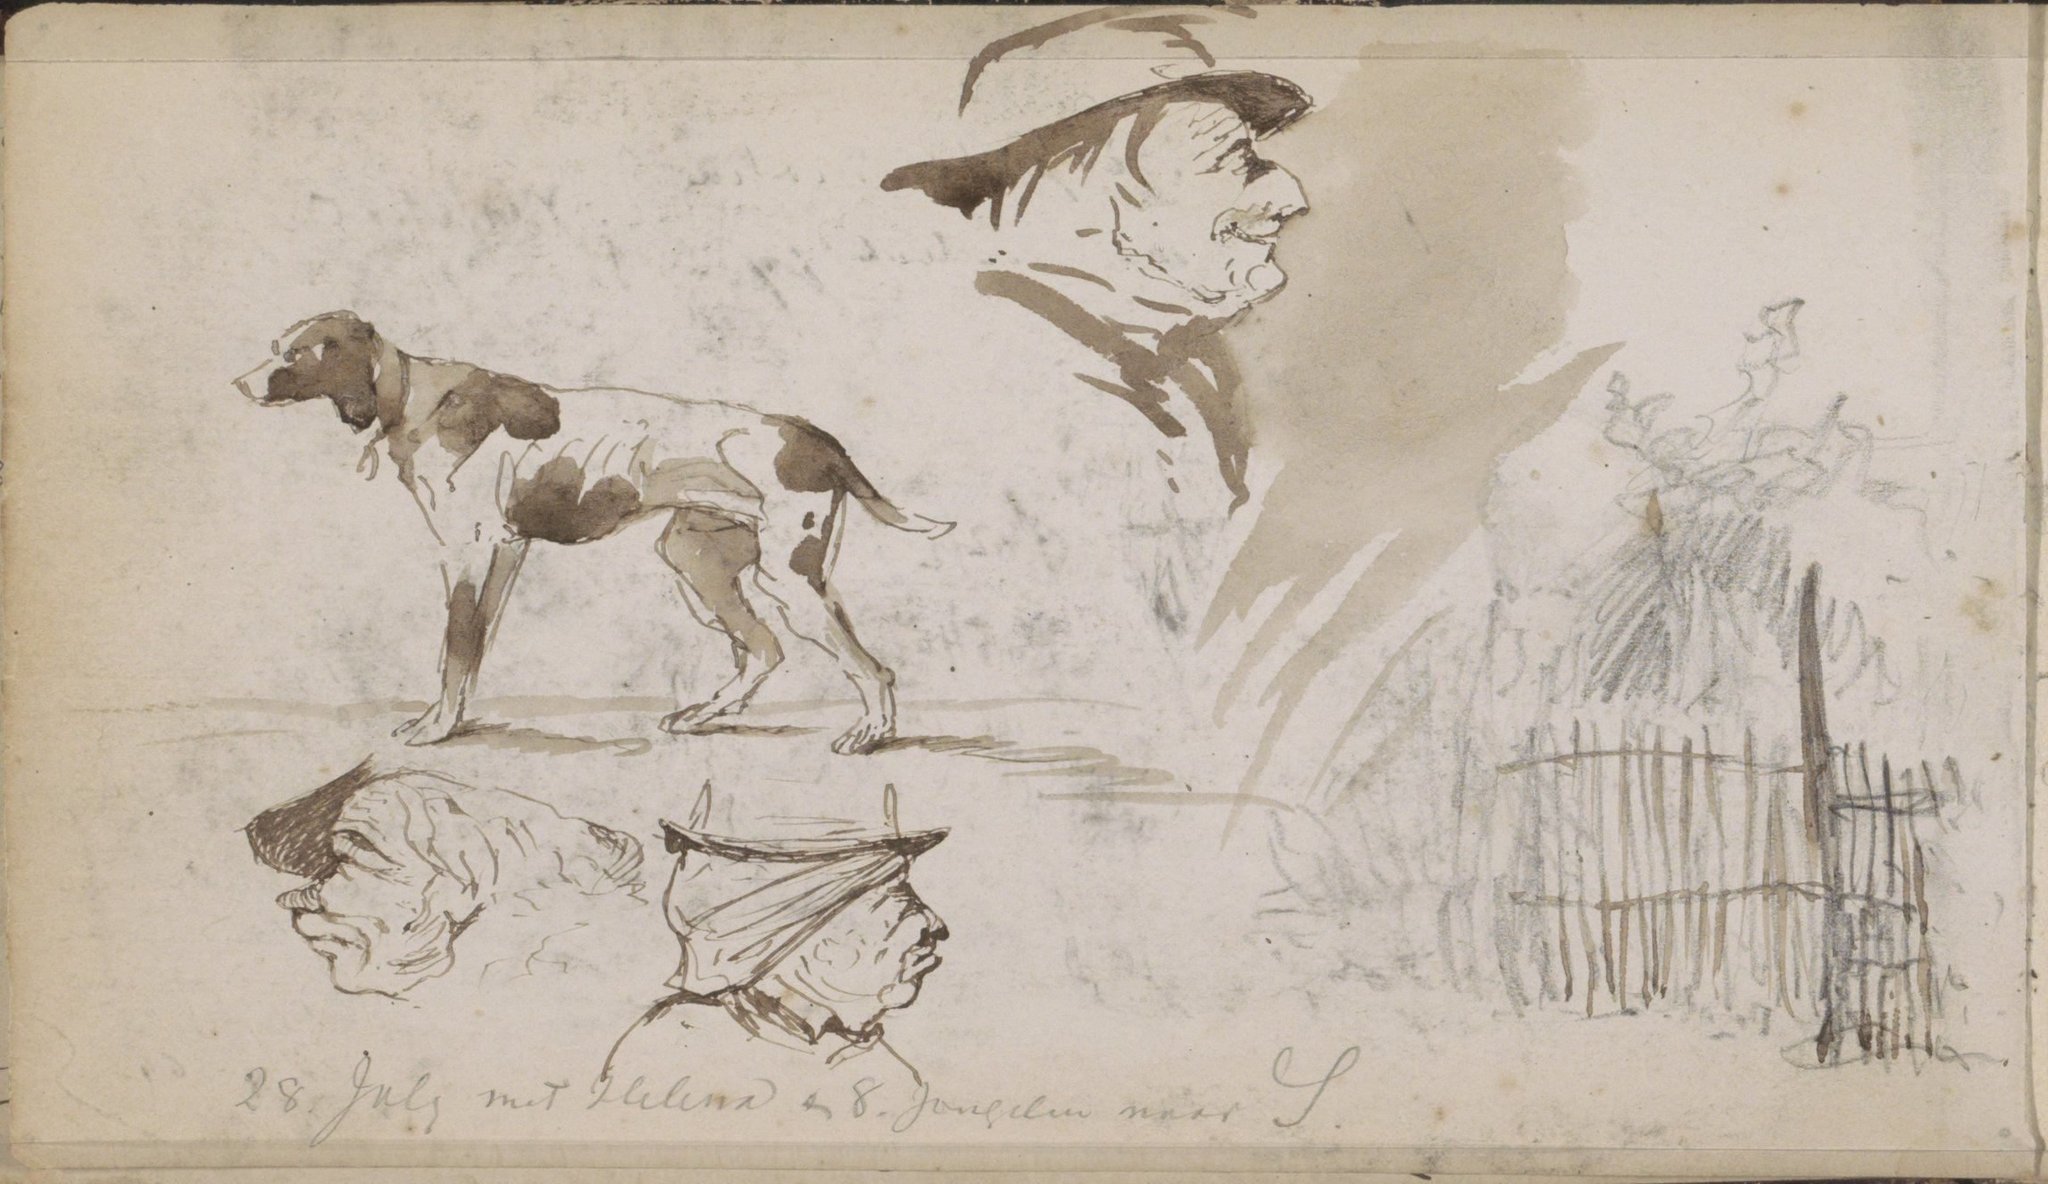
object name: sketchbook leaf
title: Hond en twee mannenkoppen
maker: johannes tavenraat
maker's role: draughtsman, painter, print maker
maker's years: 1809-1881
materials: ink, paper, pencil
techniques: pen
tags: head (human), adult man, head-gear: hat (+ men's clothes), dog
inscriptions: date and inscription: ‘28 July met Helena & 8. Jongelin naar S’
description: Blad 1 verso uit een schetsboek met 98 bladen.